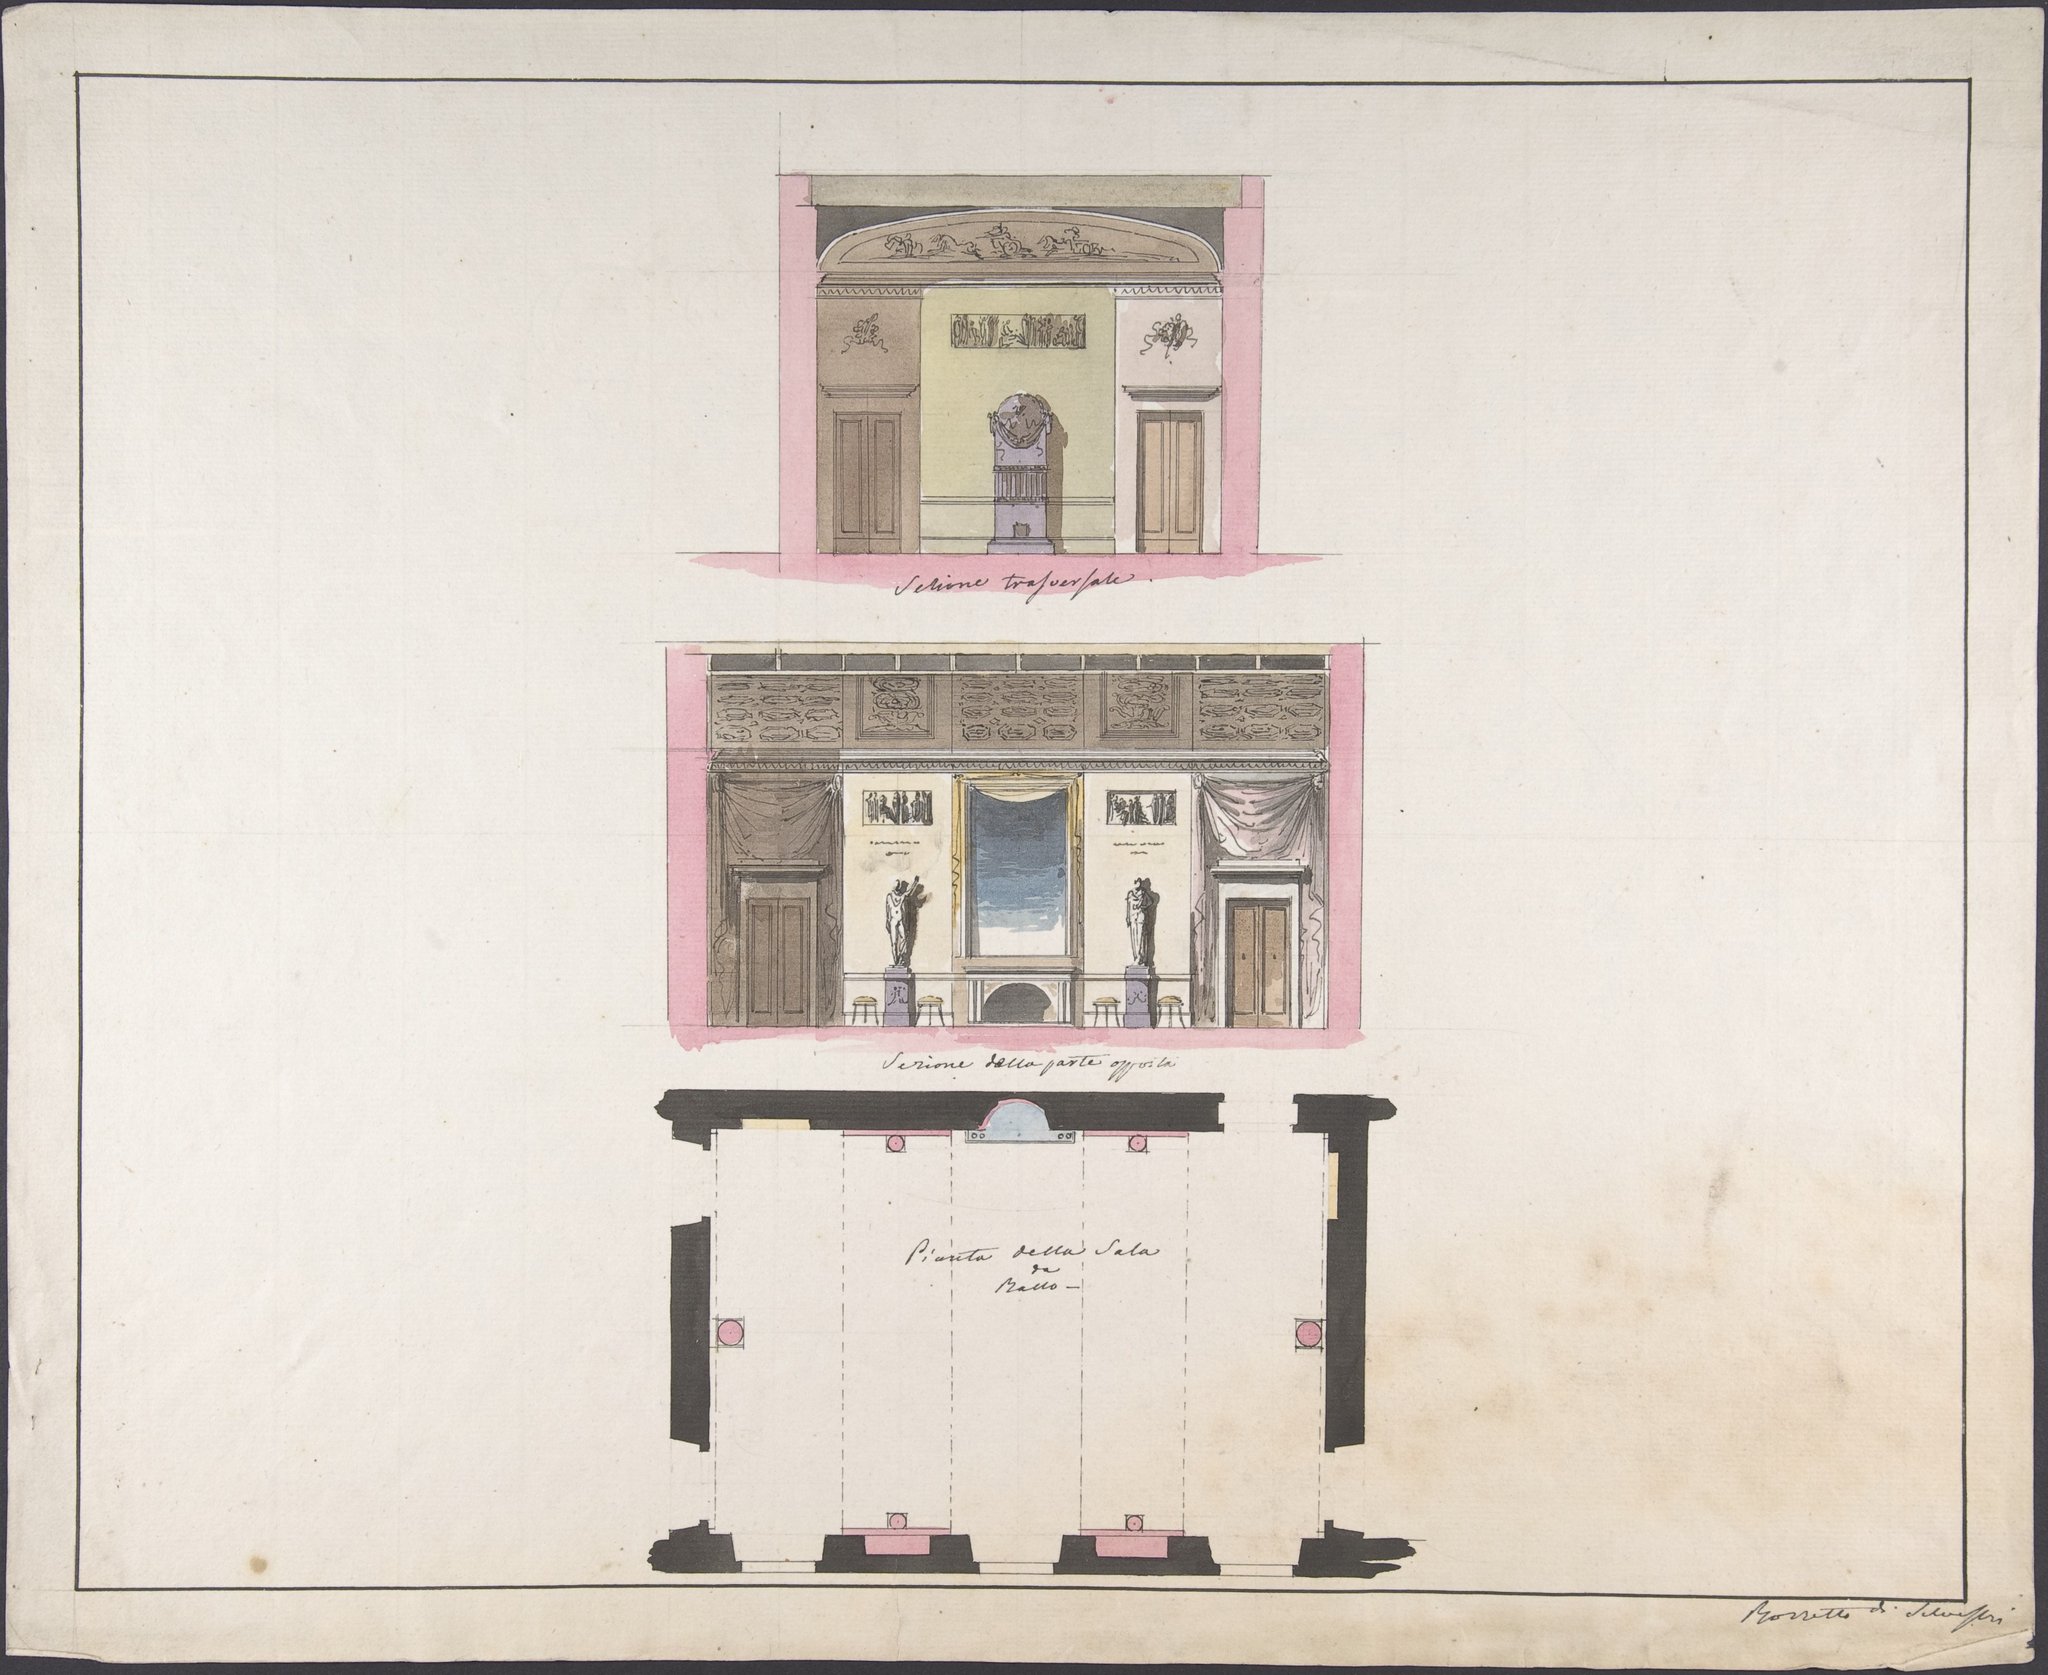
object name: drawing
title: Elevation "della nuova Galleria"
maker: giovanni battista silvestri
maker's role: artist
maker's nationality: italian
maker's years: 1796-1873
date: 1796-1873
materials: ink, paper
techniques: pen, wash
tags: architecture,interiors